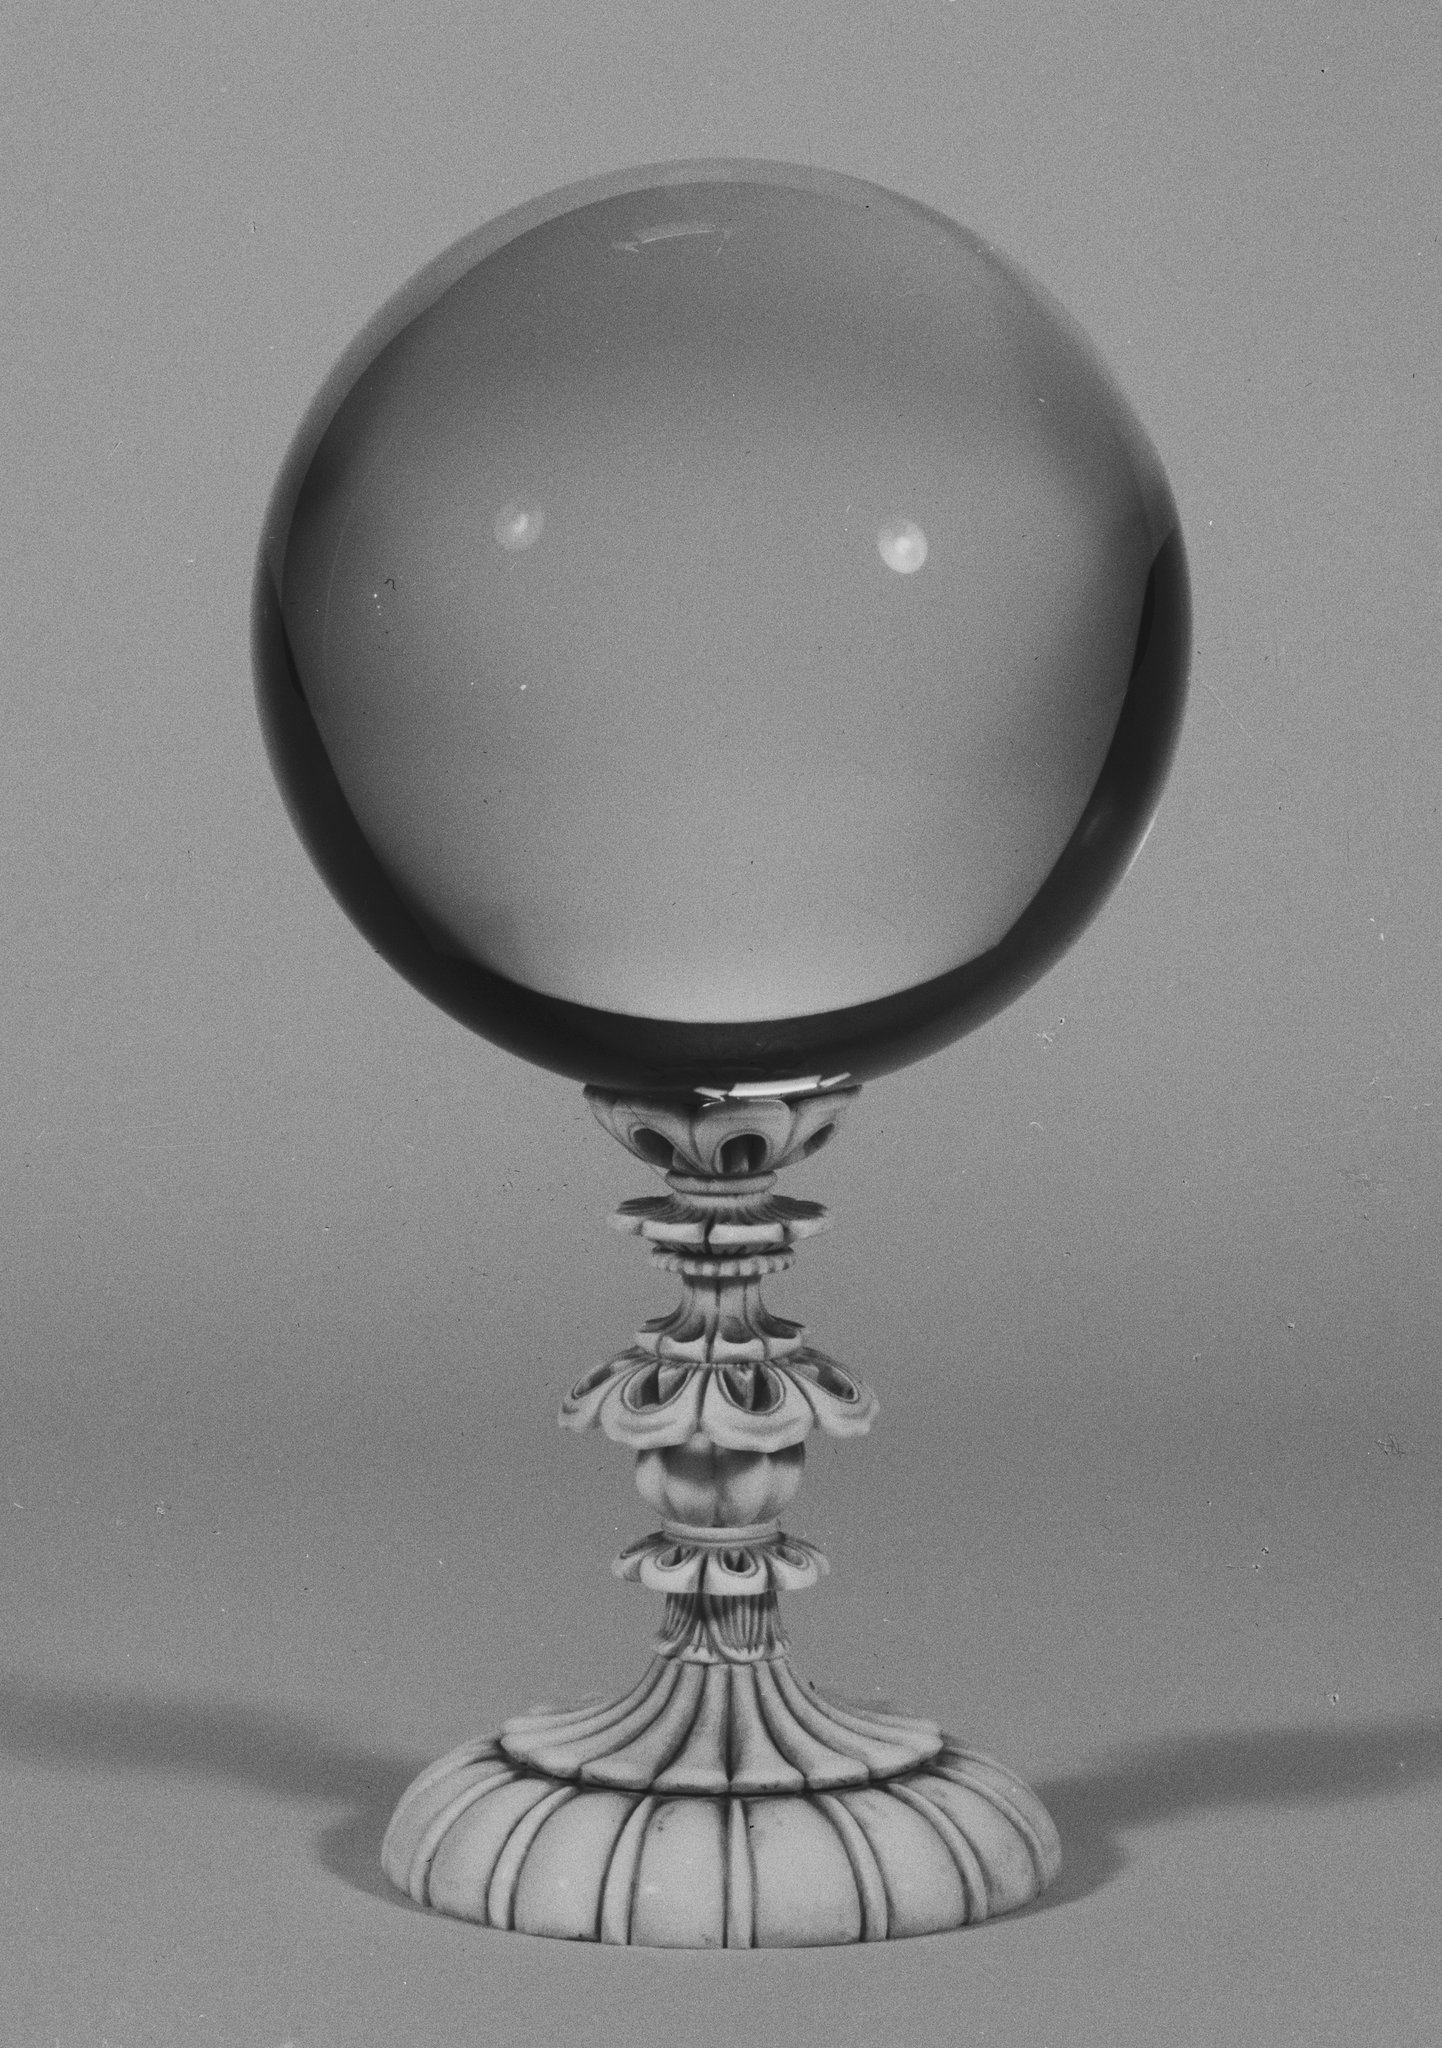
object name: crystal ball on stand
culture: chinese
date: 1901-2000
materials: crystal